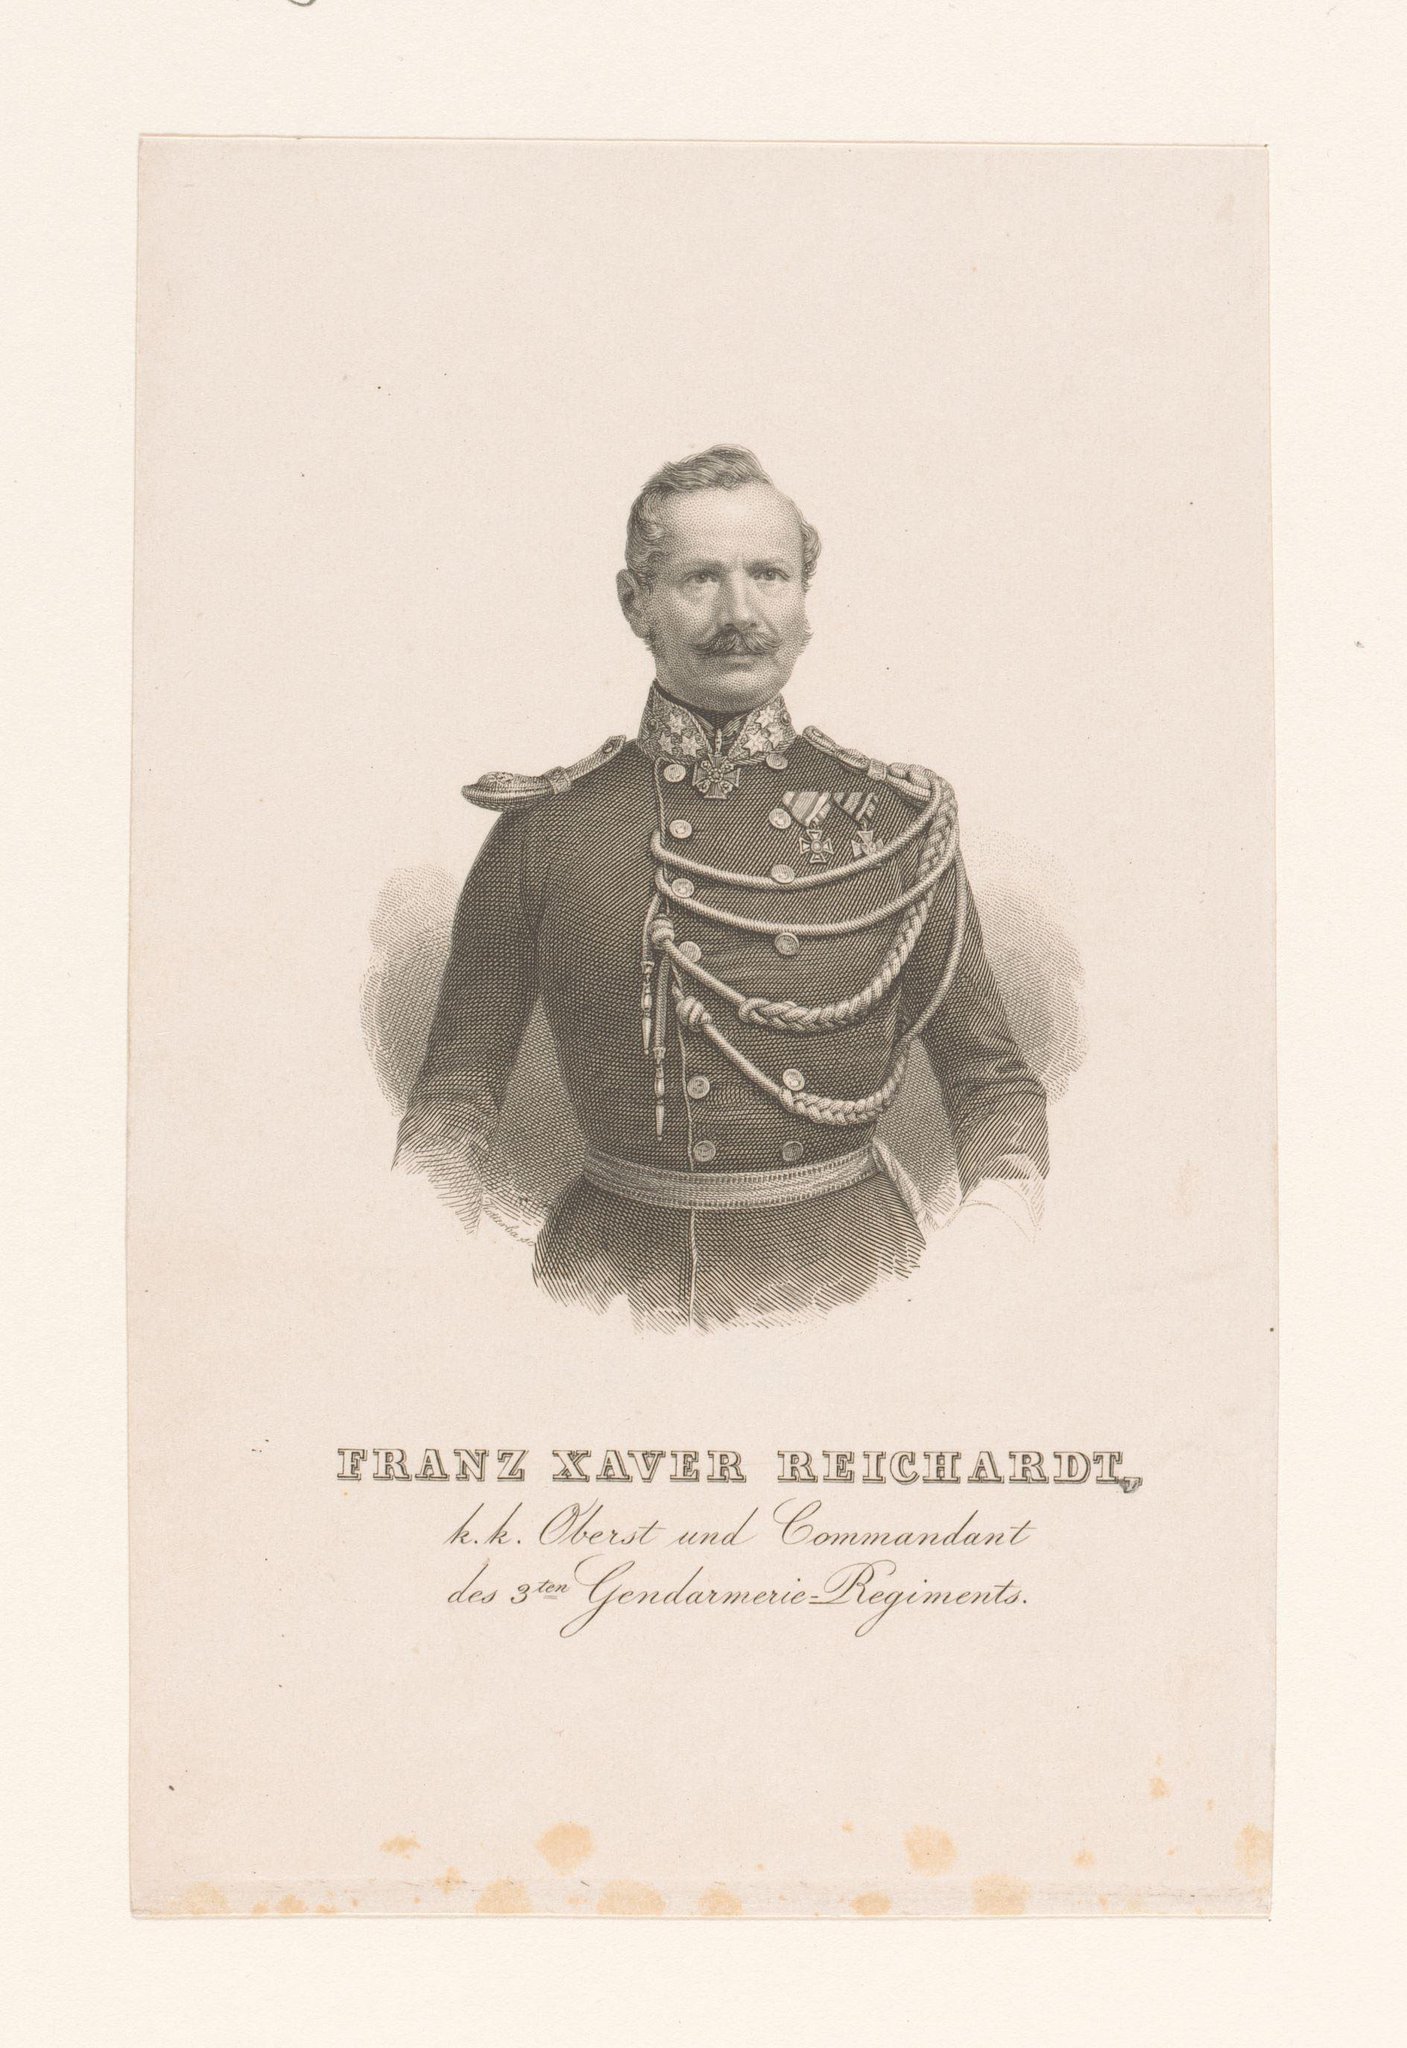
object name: book illustration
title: Franz Xaver Reichardt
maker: carl kotterba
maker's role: print maker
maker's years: 1800-1859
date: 1857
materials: paper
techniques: engraving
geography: vienna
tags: historical persons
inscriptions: collector's mark: Lugt 2228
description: Prent uit: Ehrenstein, Friedrich. Oesterreichischer Gendarmerie-Almanach für 1857. Wenen: Kaiserlich-Königlich Hof und Staatsdruckerei, 1857, p. 7.